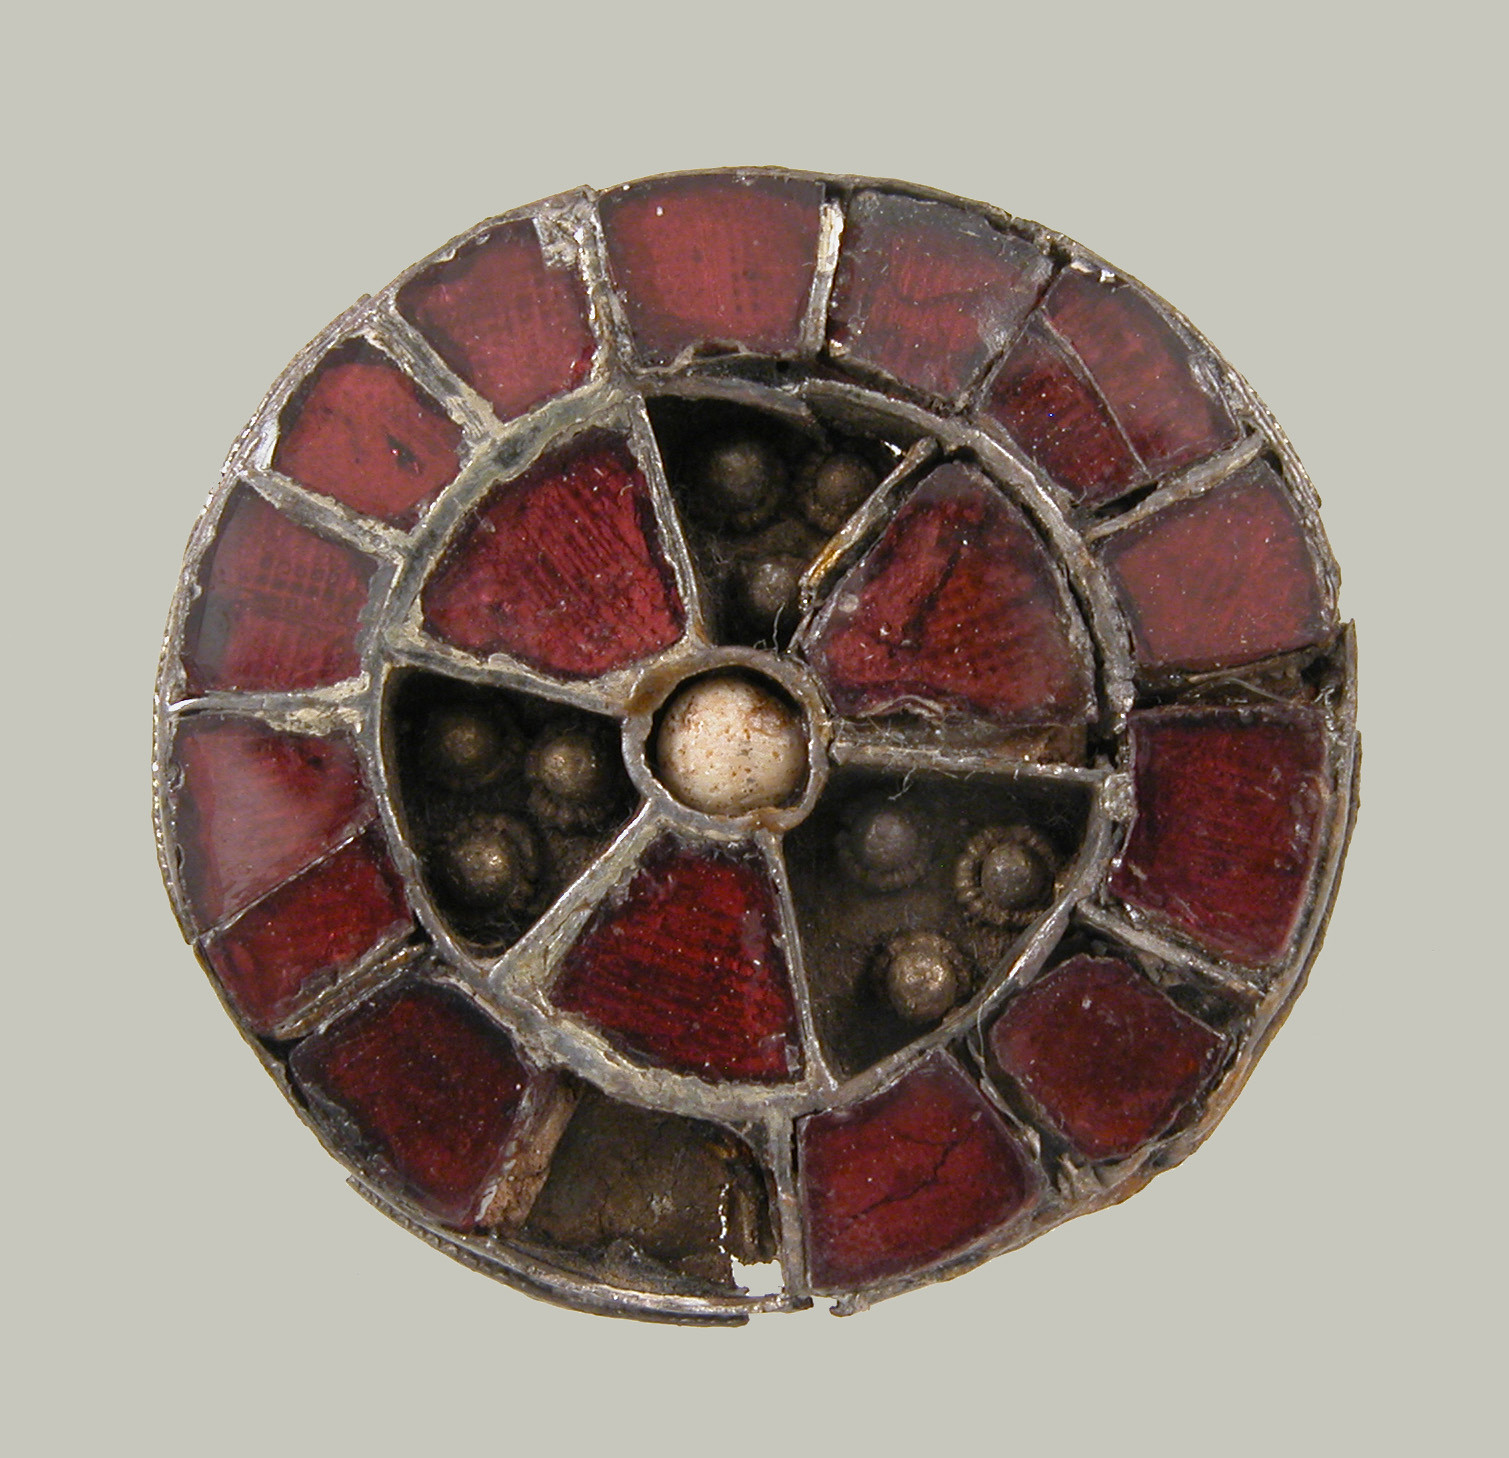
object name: brooch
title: Disk Brooch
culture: frankish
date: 601-650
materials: foil, gemstone, glass, iron, metal, paste, silver